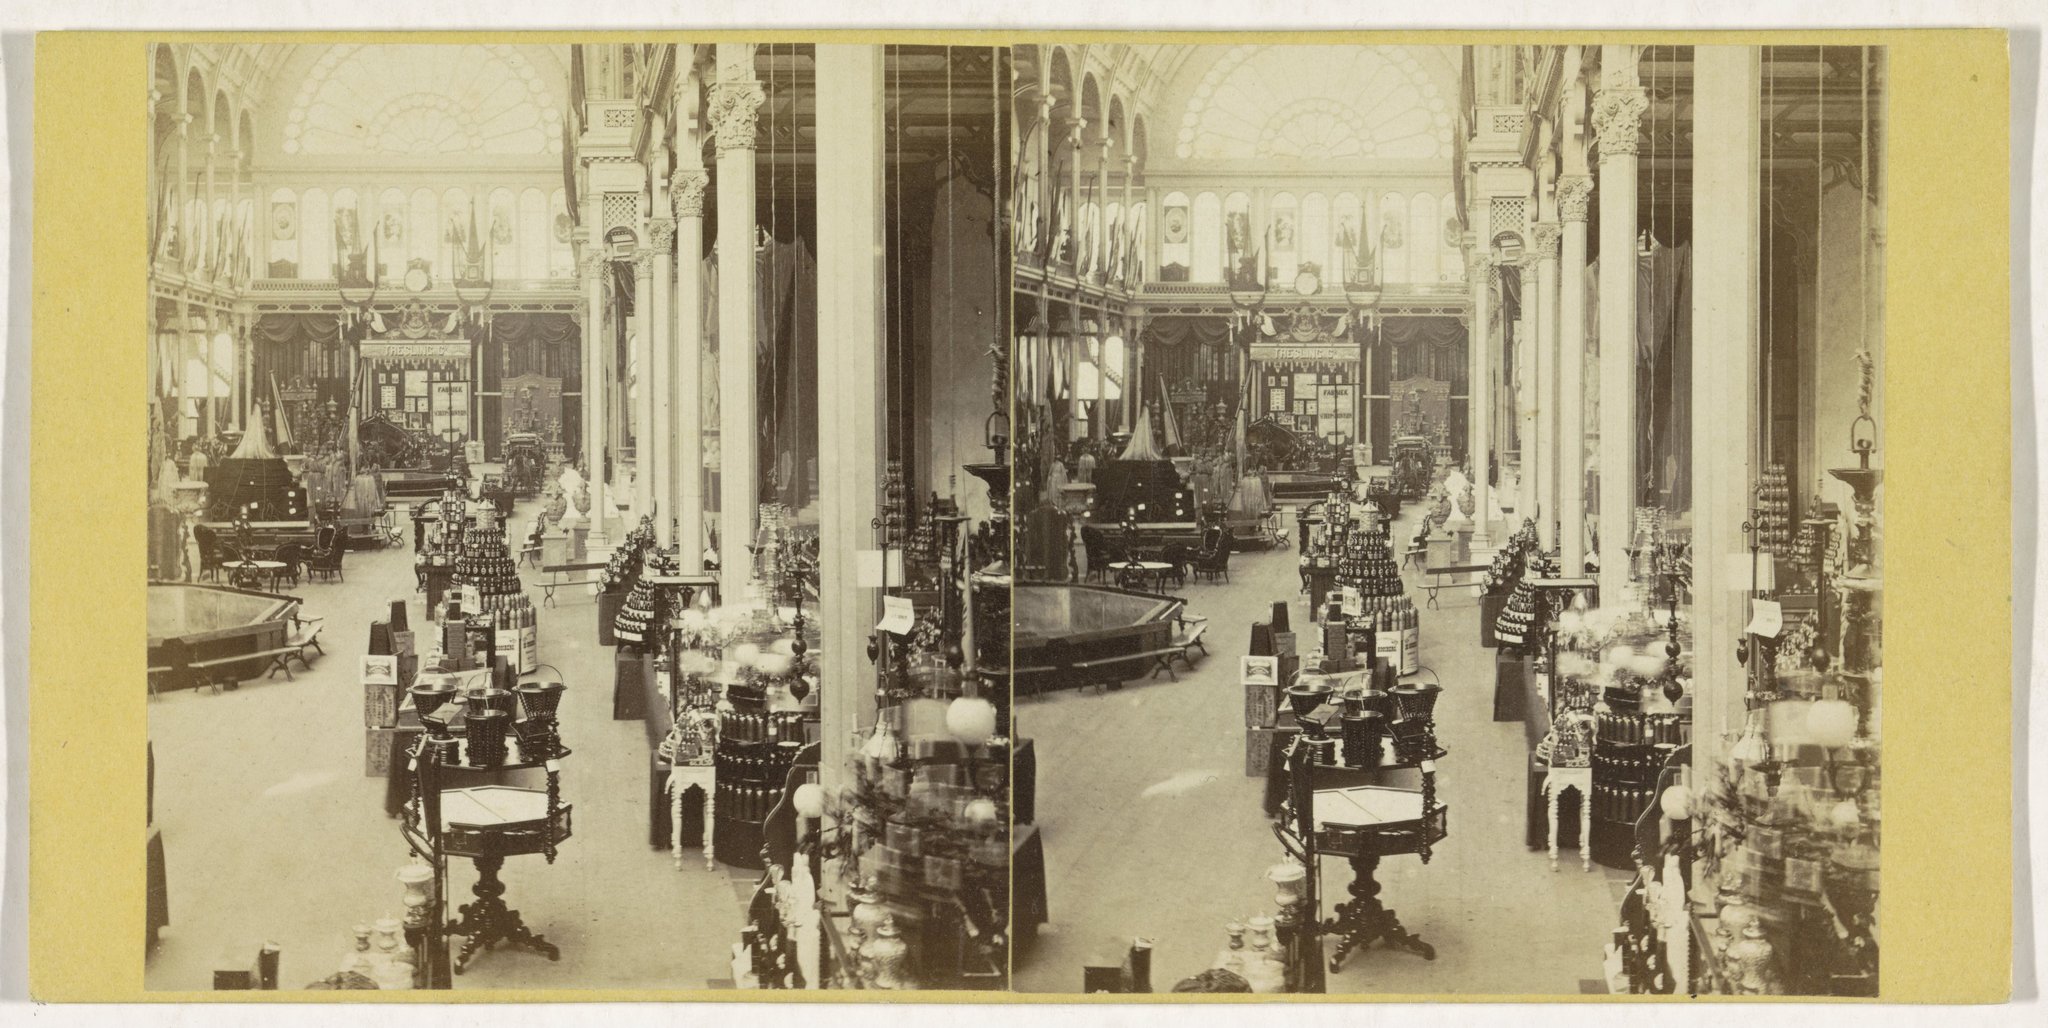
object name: stereograph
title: Zaal met uitgestalde objecten bij de Tentoonstelling voor Nationale Nijverheid en Kunst in het Paleis voor Volksvlijt, Amsterdam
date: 1866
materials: cardboard, paper, photographic support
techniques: albumen print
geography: amsterdam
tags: paleis voor volksvlijt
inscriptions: label: ‘Boek & Kunsthandel Jan D. Brouwer, Kalverstraat E, Nº 37 Amsterdam.’, stamp: ‘JDB’